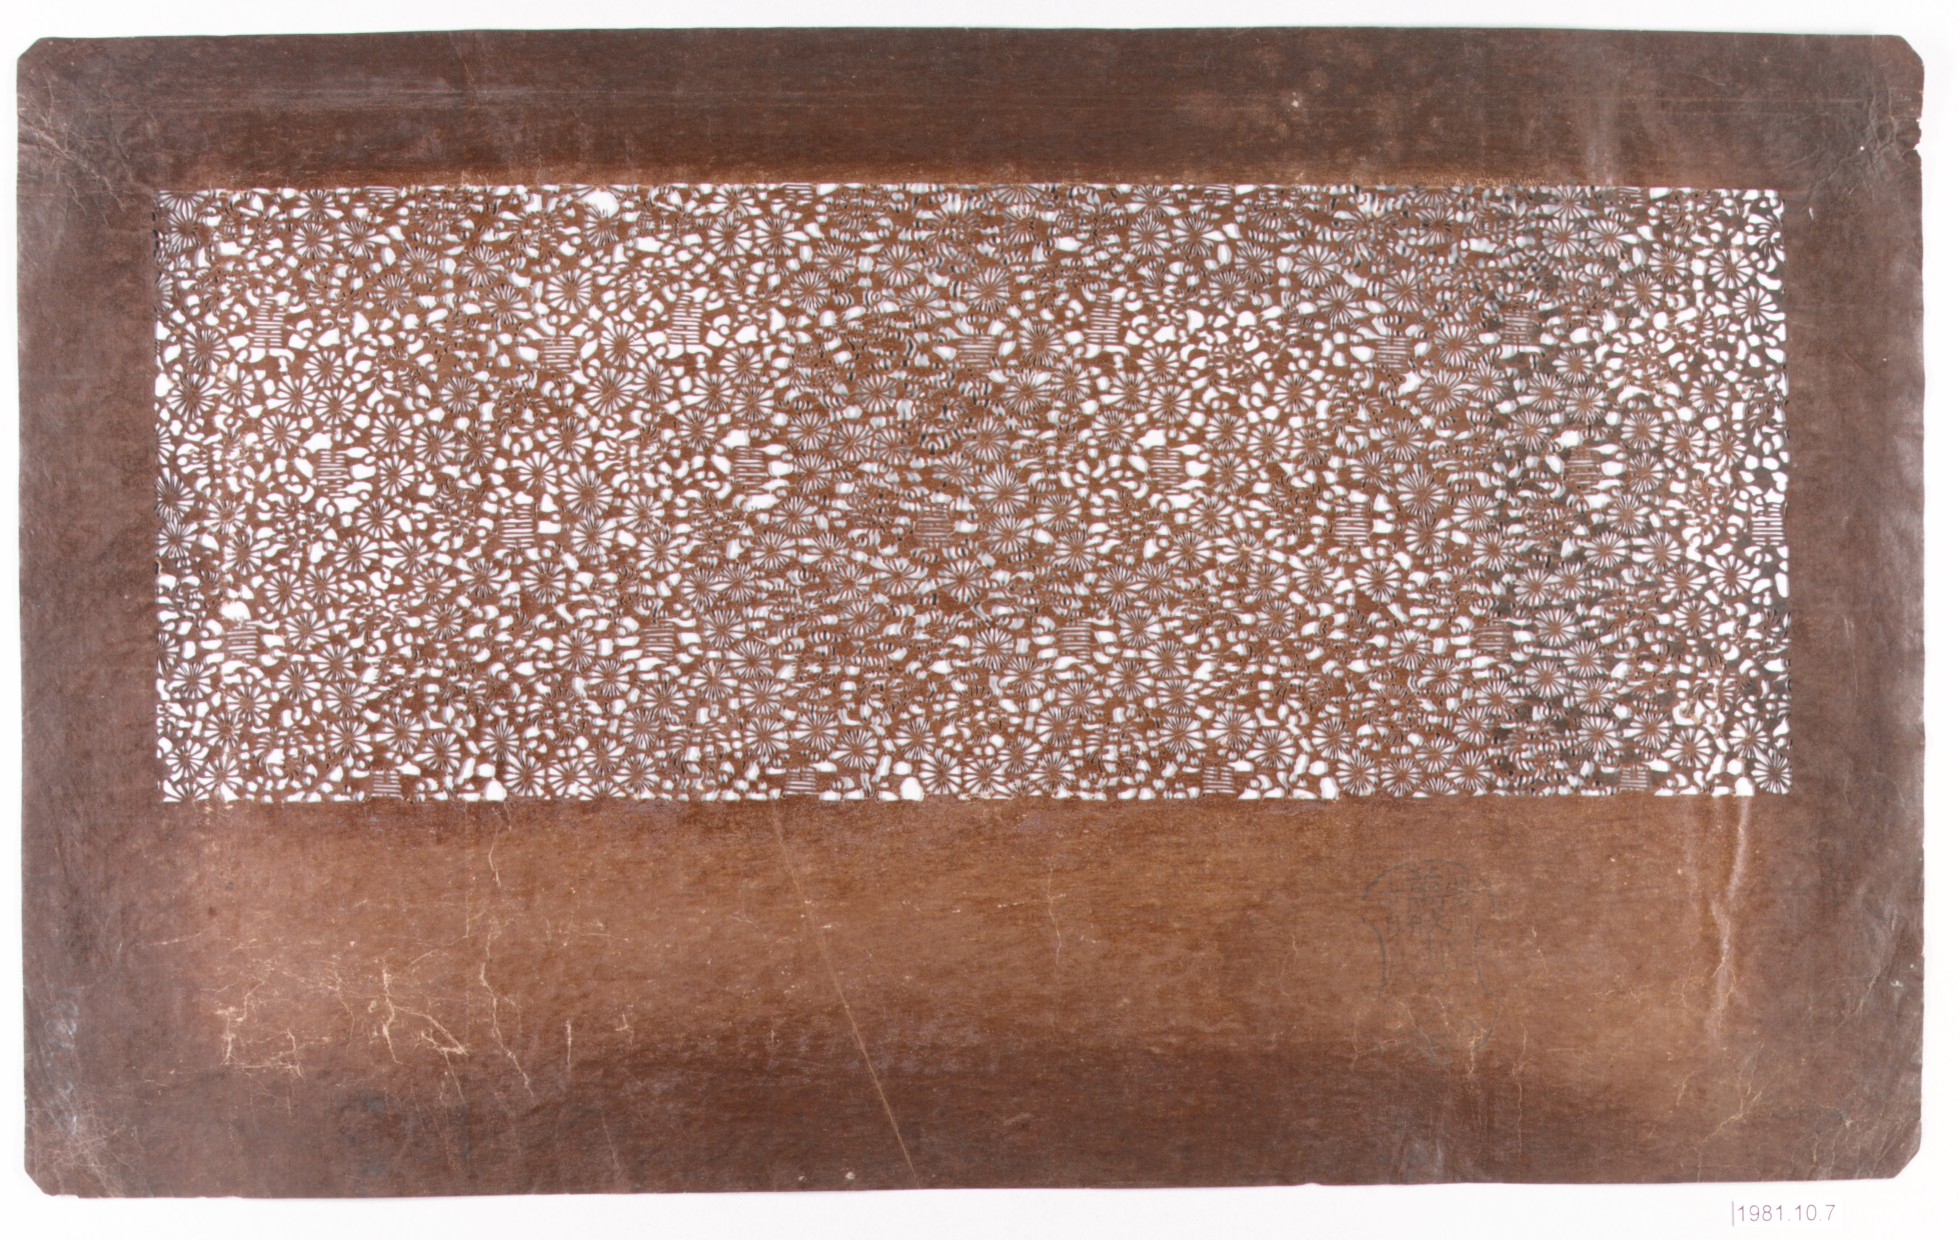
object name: stencil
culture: japanese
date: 1801-1900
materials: paper